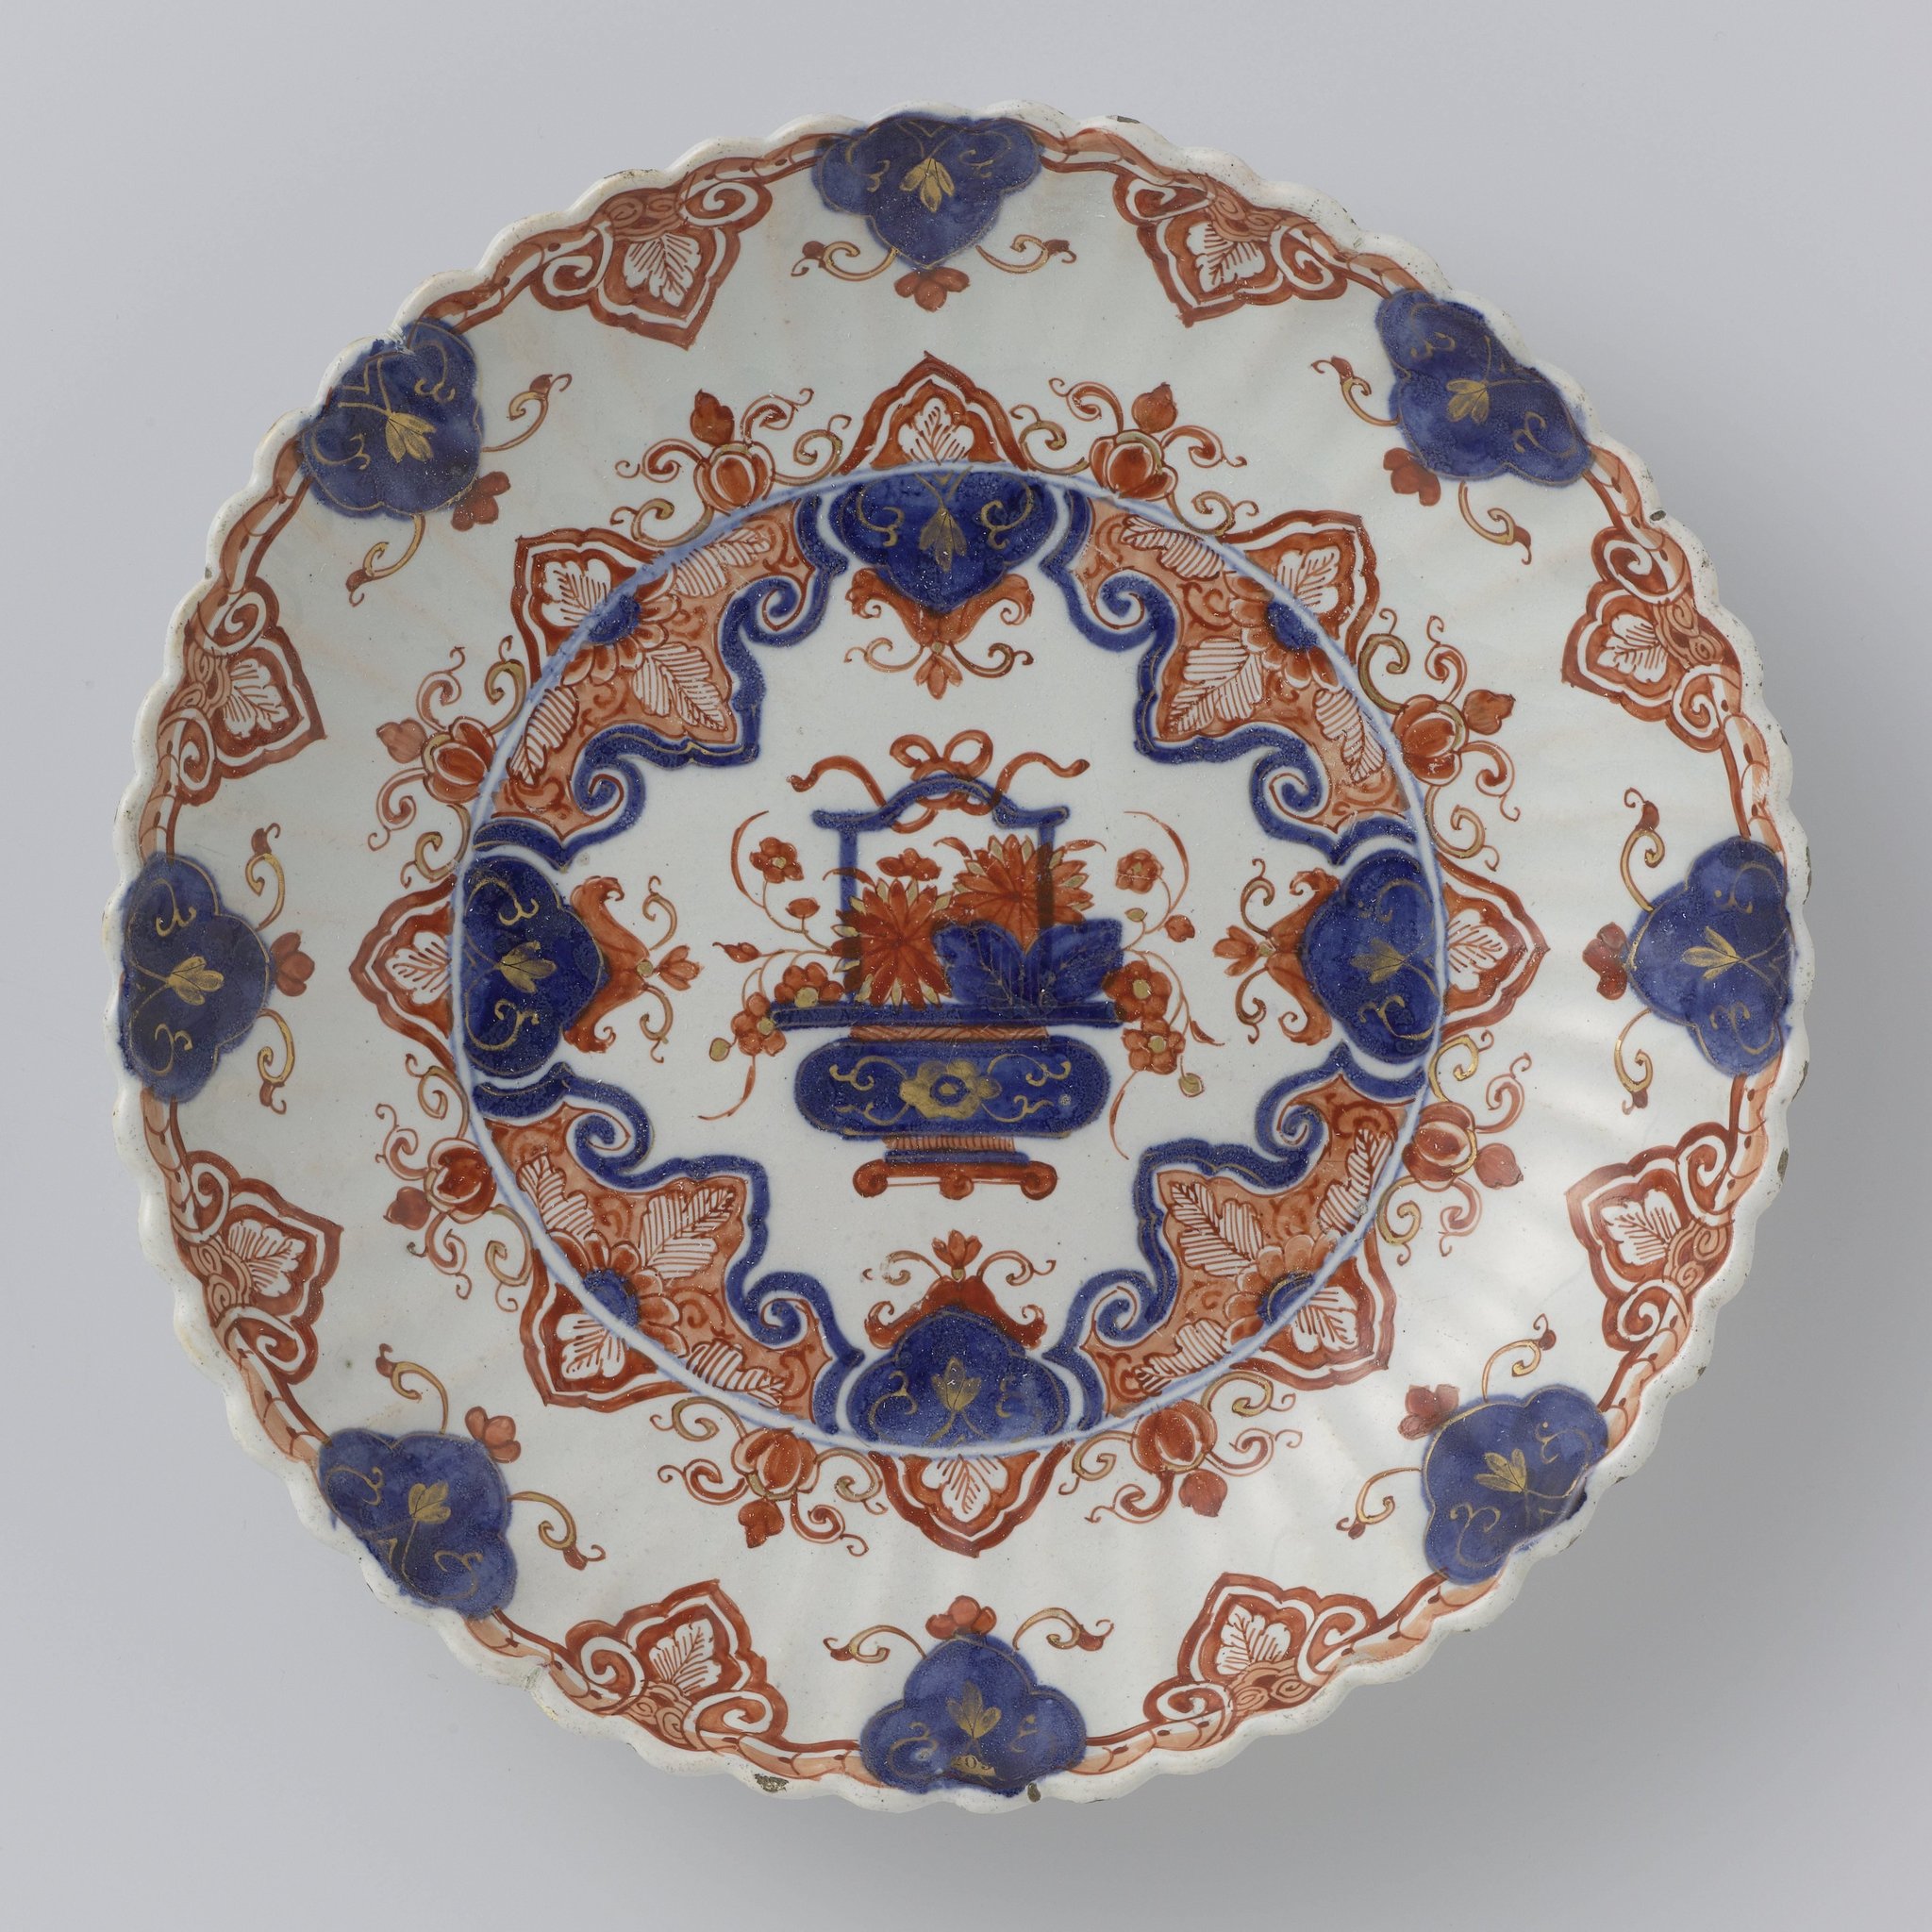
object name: dish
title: Schaal, versierd met bloemenmand binnen lambrequinrand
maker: pieter adriaensz. kocx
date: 1705-1725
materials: earthenware, glaze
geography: delft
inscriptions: mark: ‘APK (ineen)’, collector's mark: ‘collection loudon’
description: Schaal, rond en geribd, van faïence. Veelkleurig beschilderd met een bloemenmand binnen een lambrequinrand.